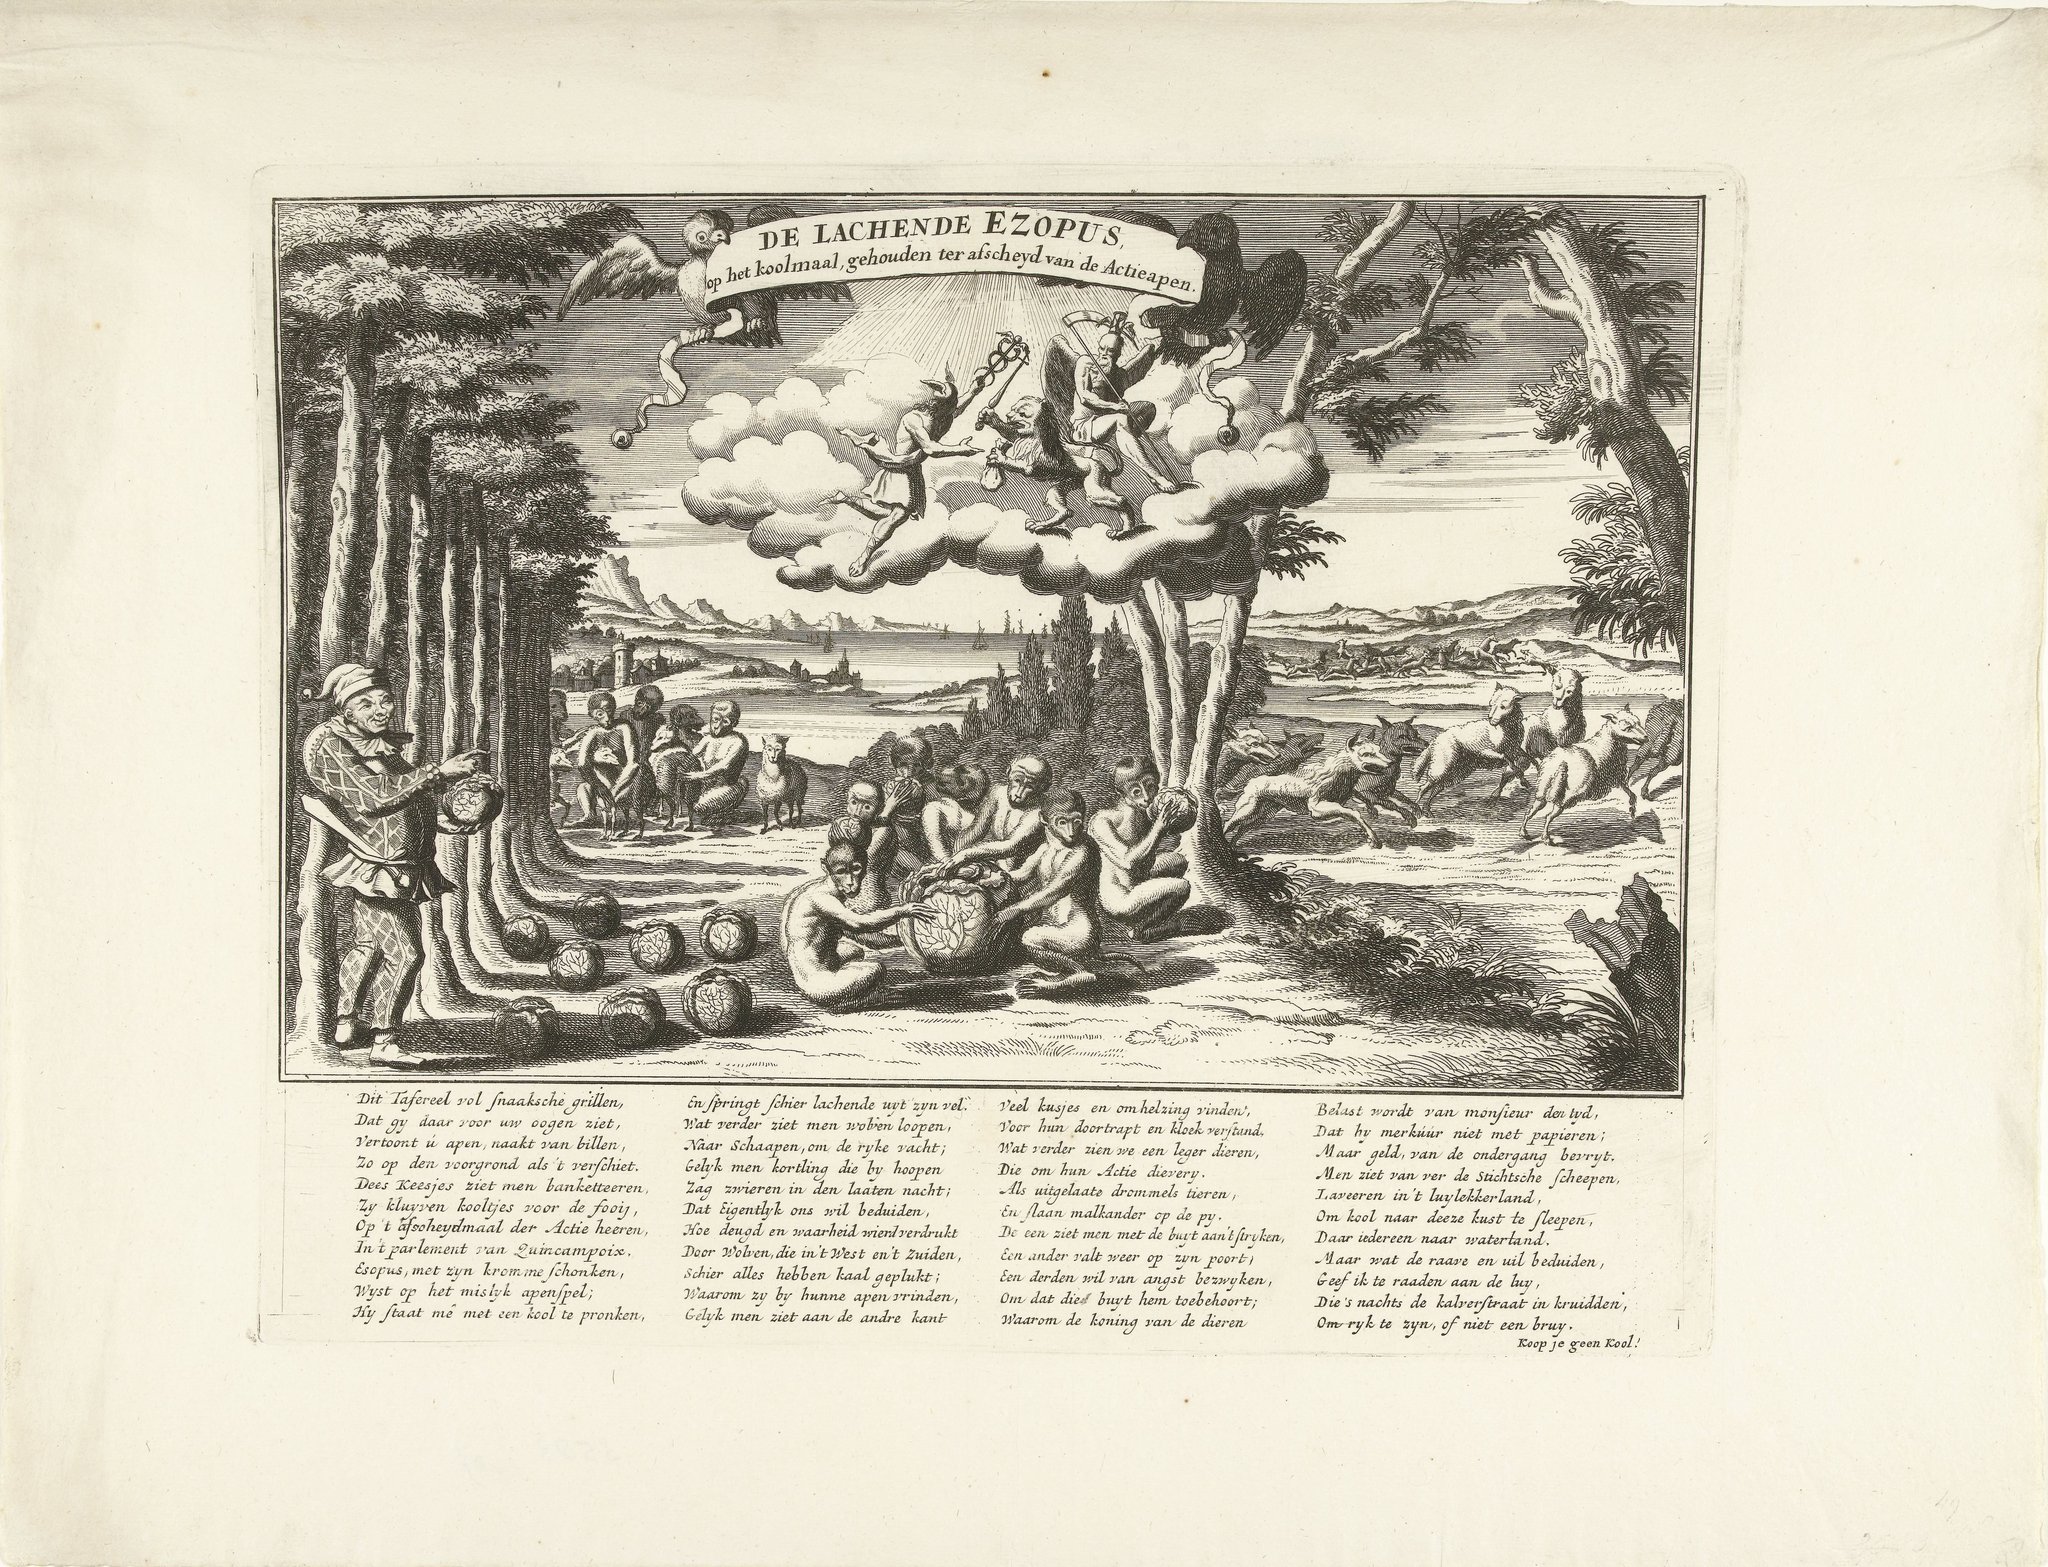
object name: print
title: De lachende Ezopus, op het koolmaal, gehouden ter afscheyd van de Actieapen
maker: Anonymous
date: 1720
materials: paper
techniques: engraving, etching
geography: northern netherlands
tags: monkeys, apes, animals acting as human beings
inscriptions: collector's mark: Lugt 2228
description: Links staat de lachende Aesopus, Bombario in harlekijnspak, bij een groep apen die kool eten (de slachtoffers van de windhandel). Rechts jagen wolven op schapen. In de wolken Mercurius, de Nederlandse Leeuw en Vader Tijd. In het onderschrift een vers in vier kolommen. Prent 48 in de serie Het Groote Tafereel der Dwaasheid met spotprenten op de Windhandel of Actiehandel van 1720.